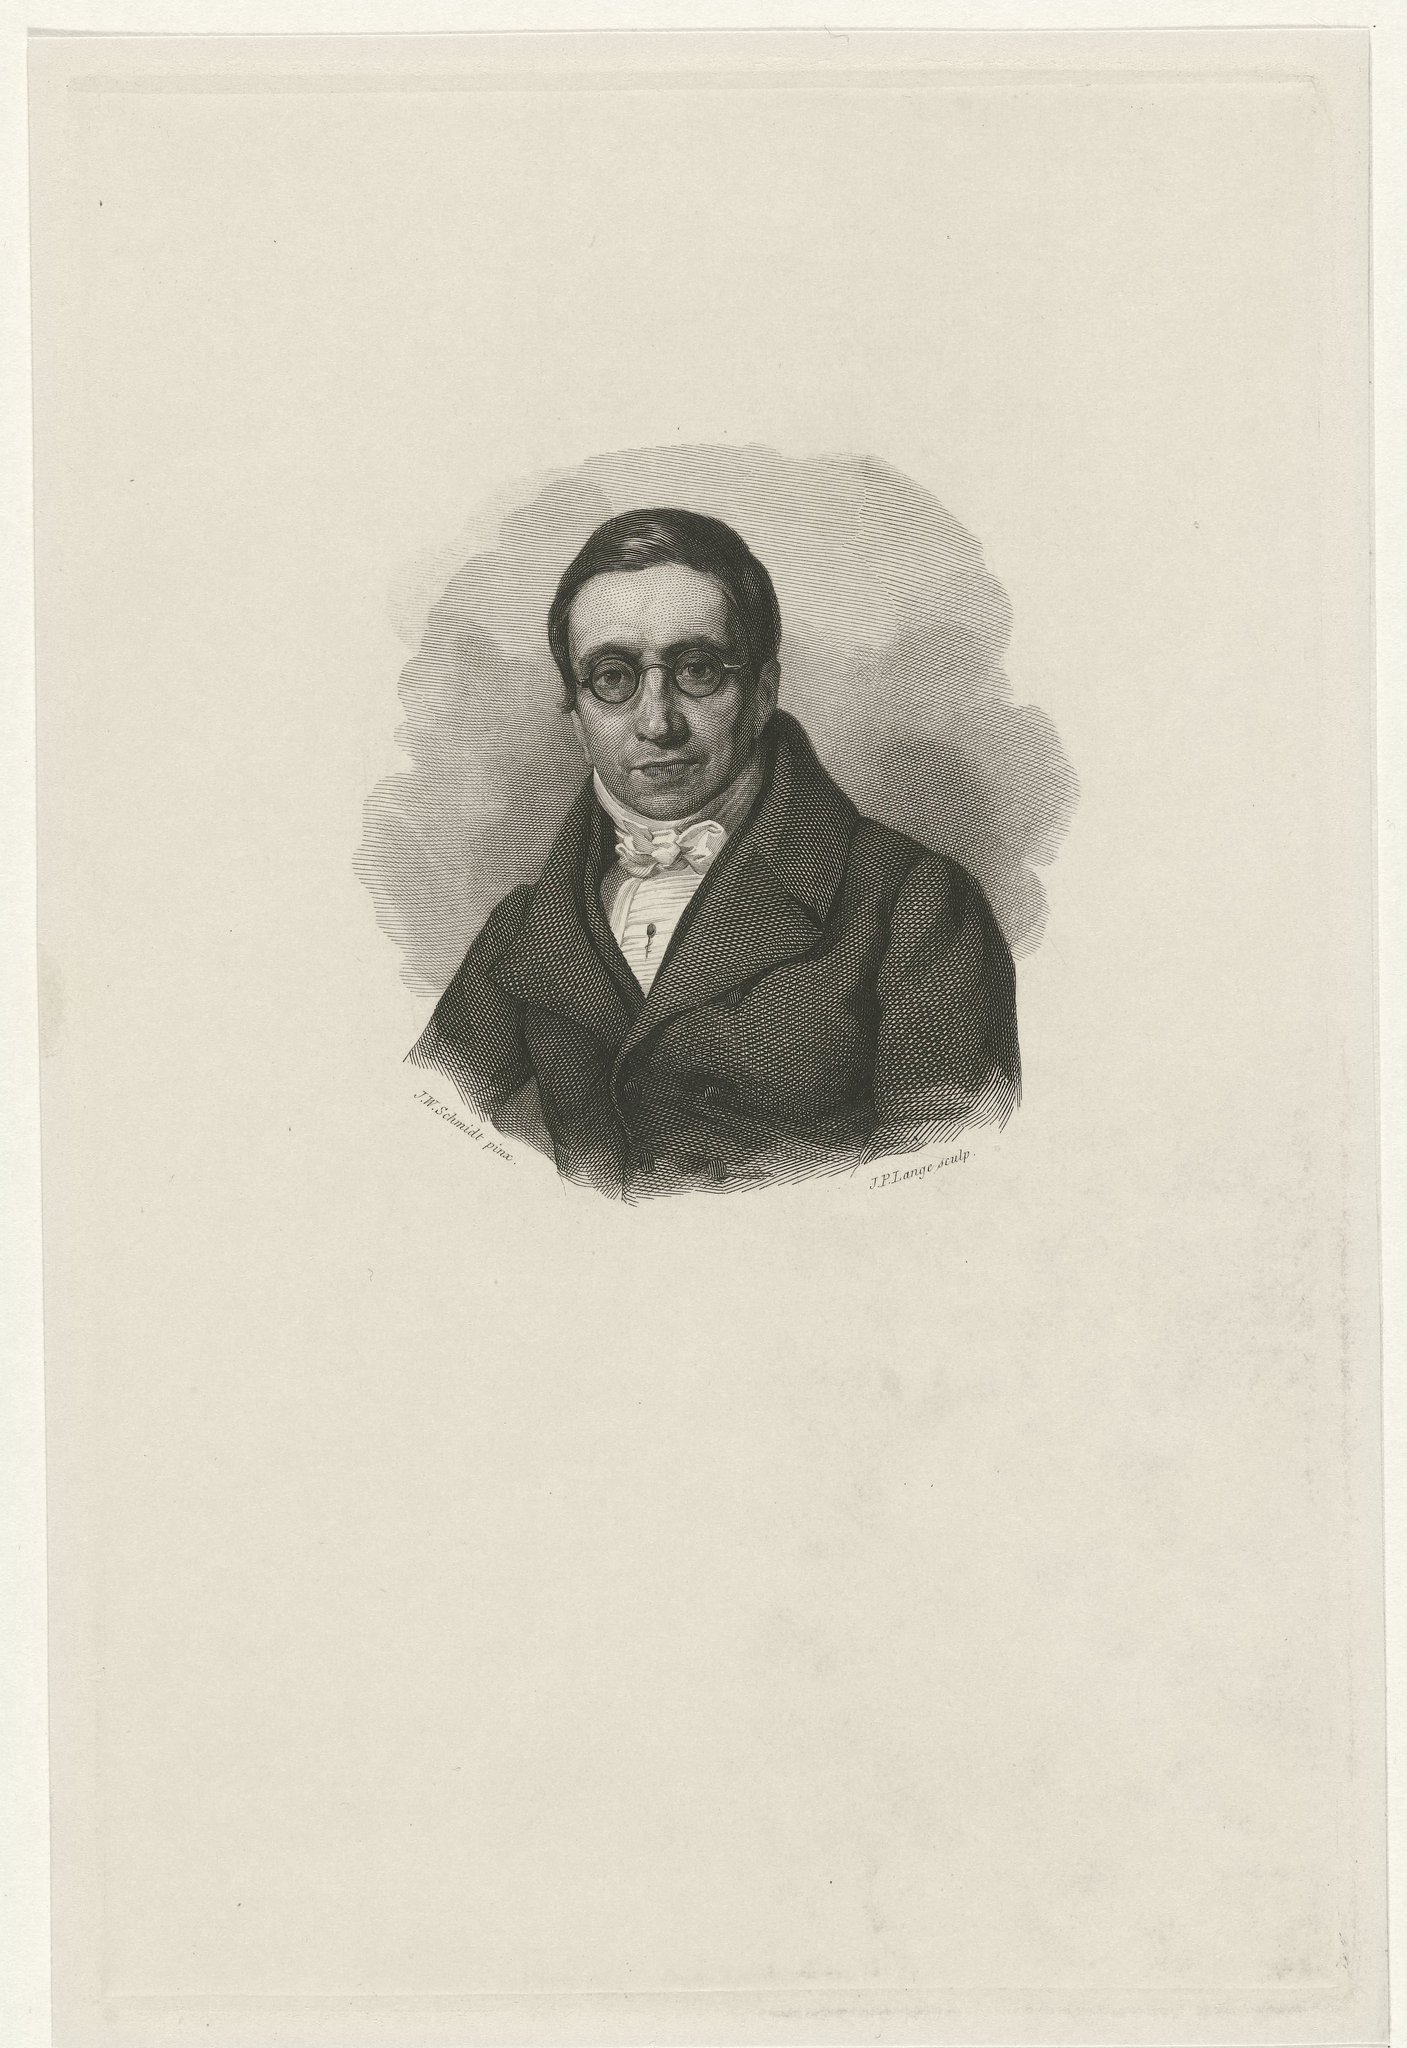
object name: print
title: Portret van een onbekende man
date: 1820-1849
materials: paper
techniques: engraving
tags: eyeglasses, spectacles, anonymous historical person portrayed alone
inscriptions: collector's mark: Lugt 2228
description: Portretbuste van voren van een onbekende man met bril, blootshoofds.